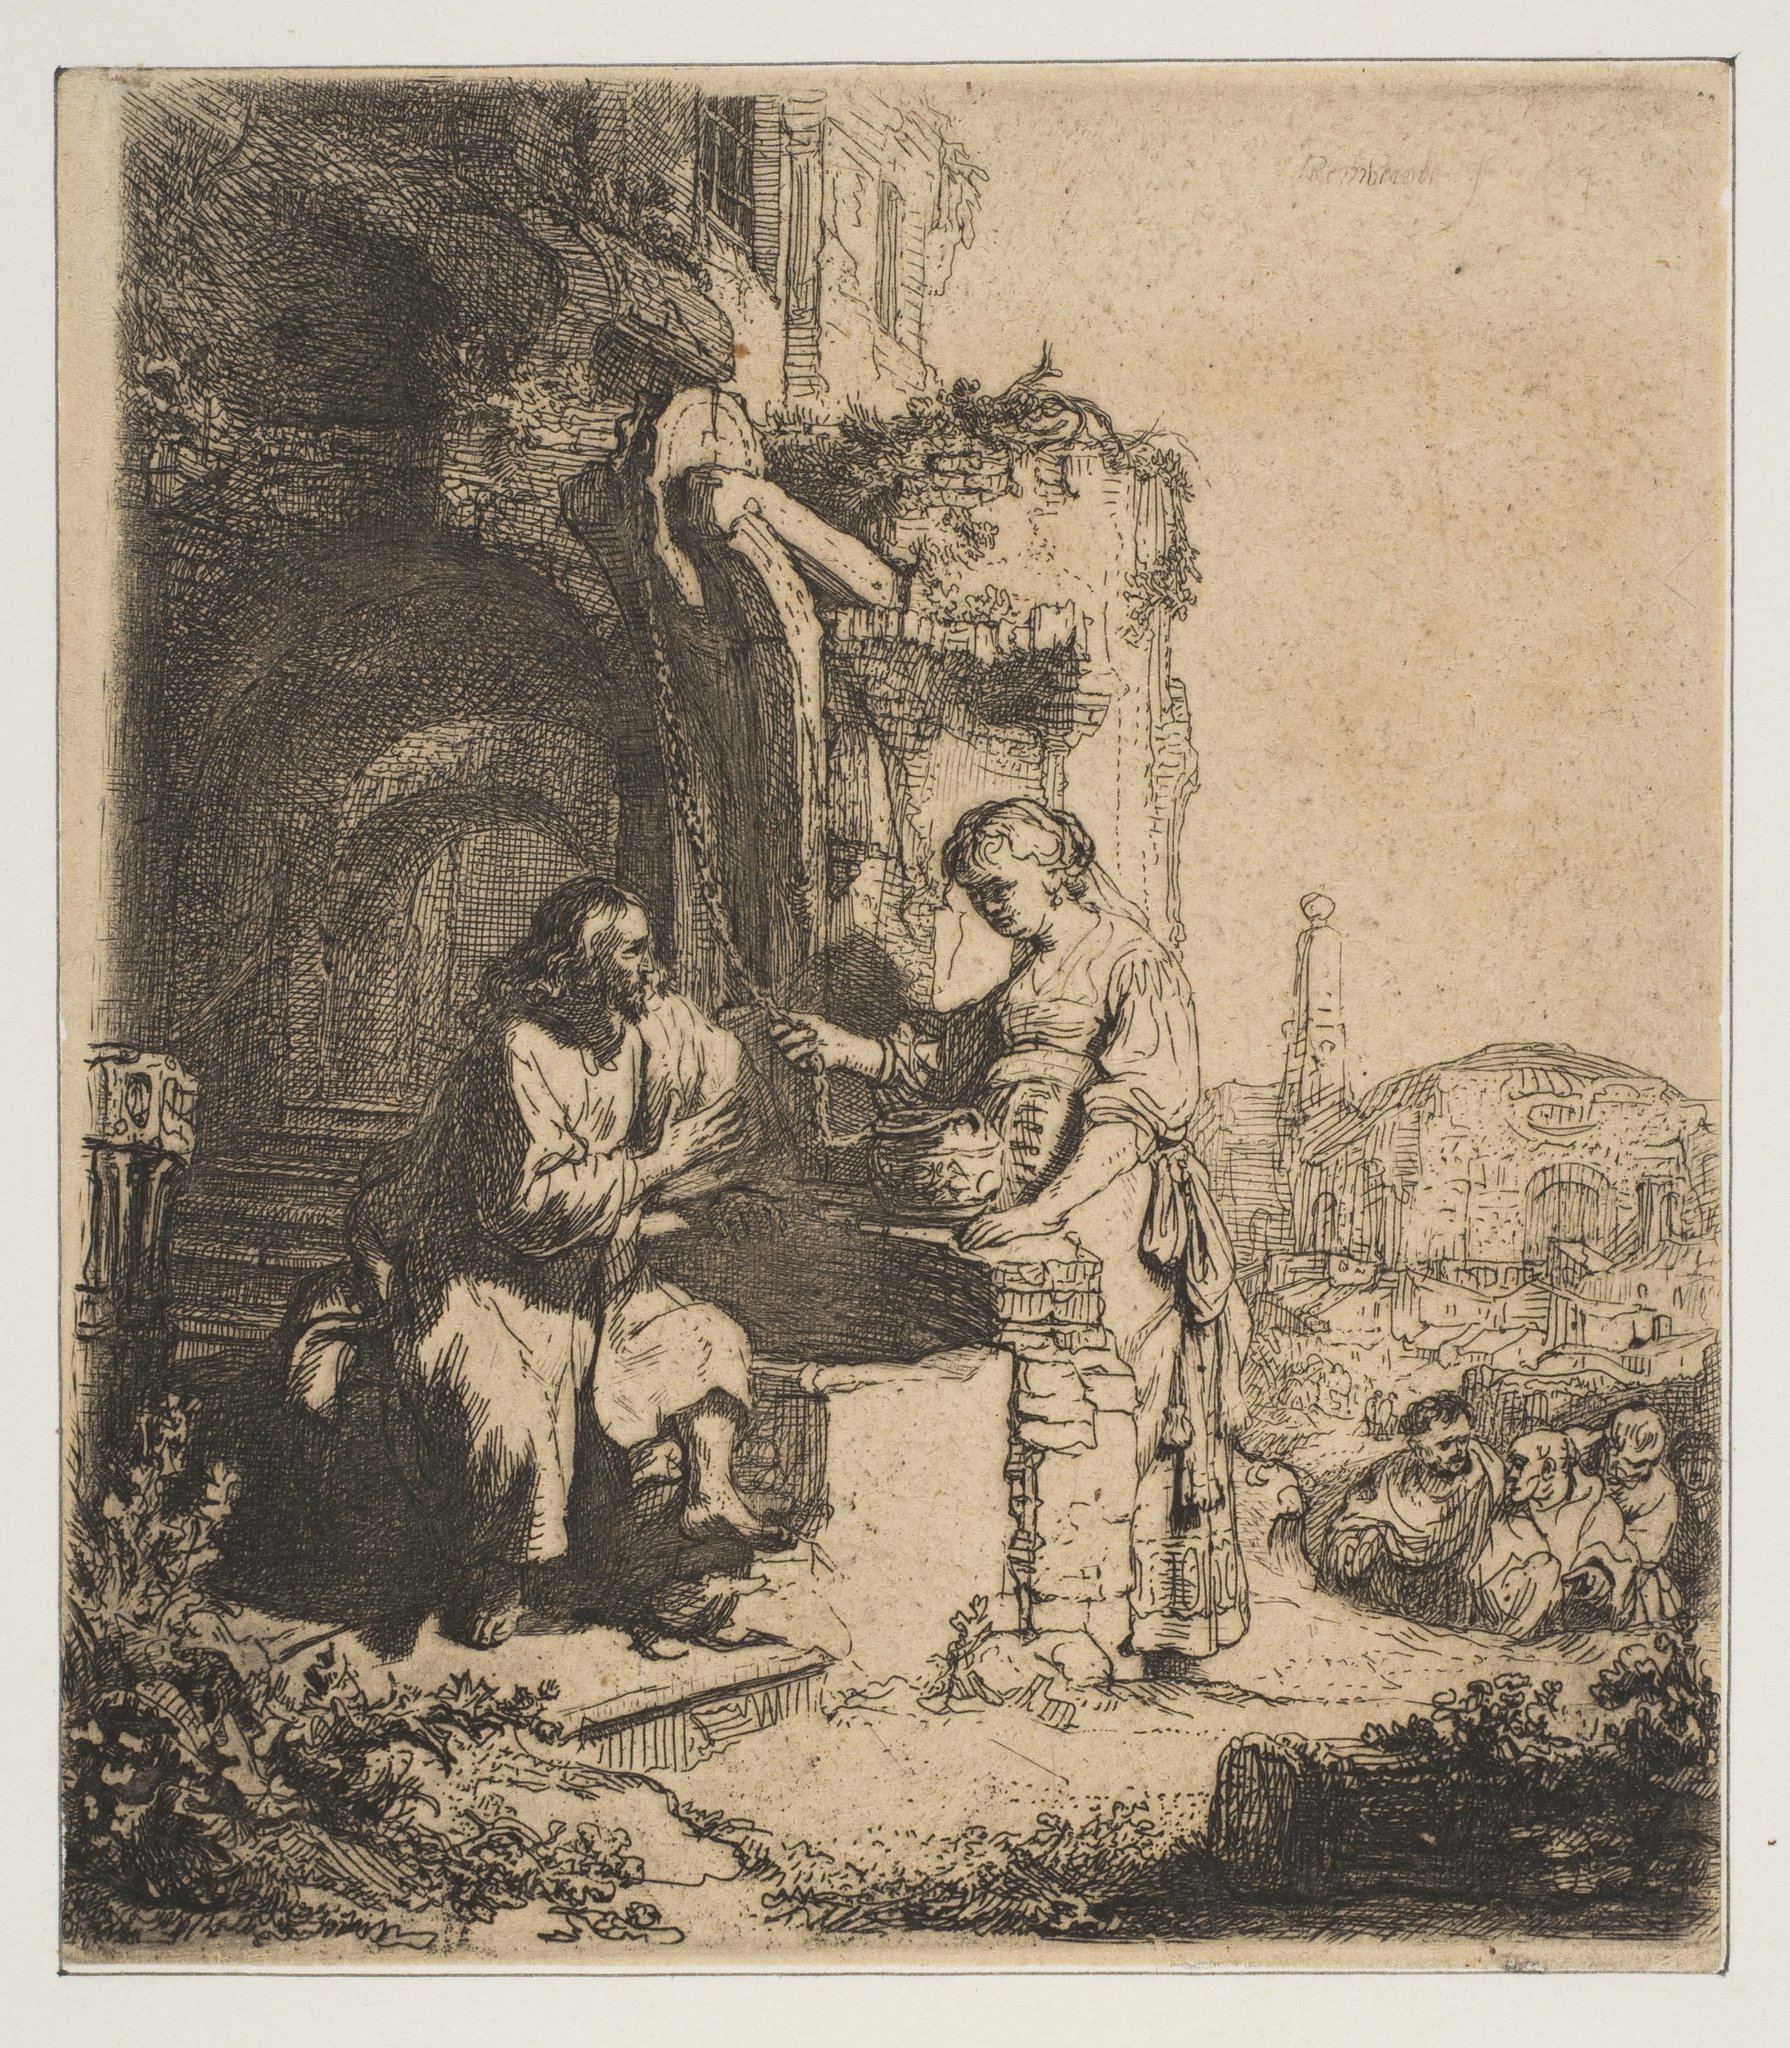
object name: print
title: Christ and the Woman of Samaria among Ruins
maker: rembrandt van rijn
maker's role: artist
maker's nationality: dutch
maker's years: 1606-1669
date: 1634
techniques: etching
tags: ruins,men,women,christ